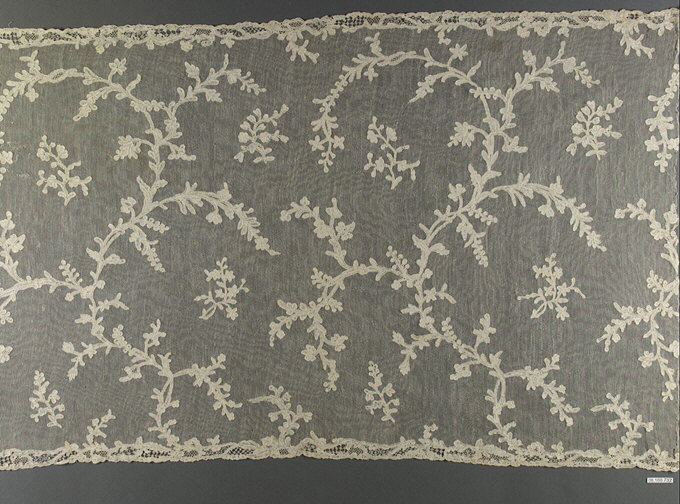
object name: scarf fragment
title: Fragment of a scarf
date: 1801-1900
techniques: lace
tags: leaves